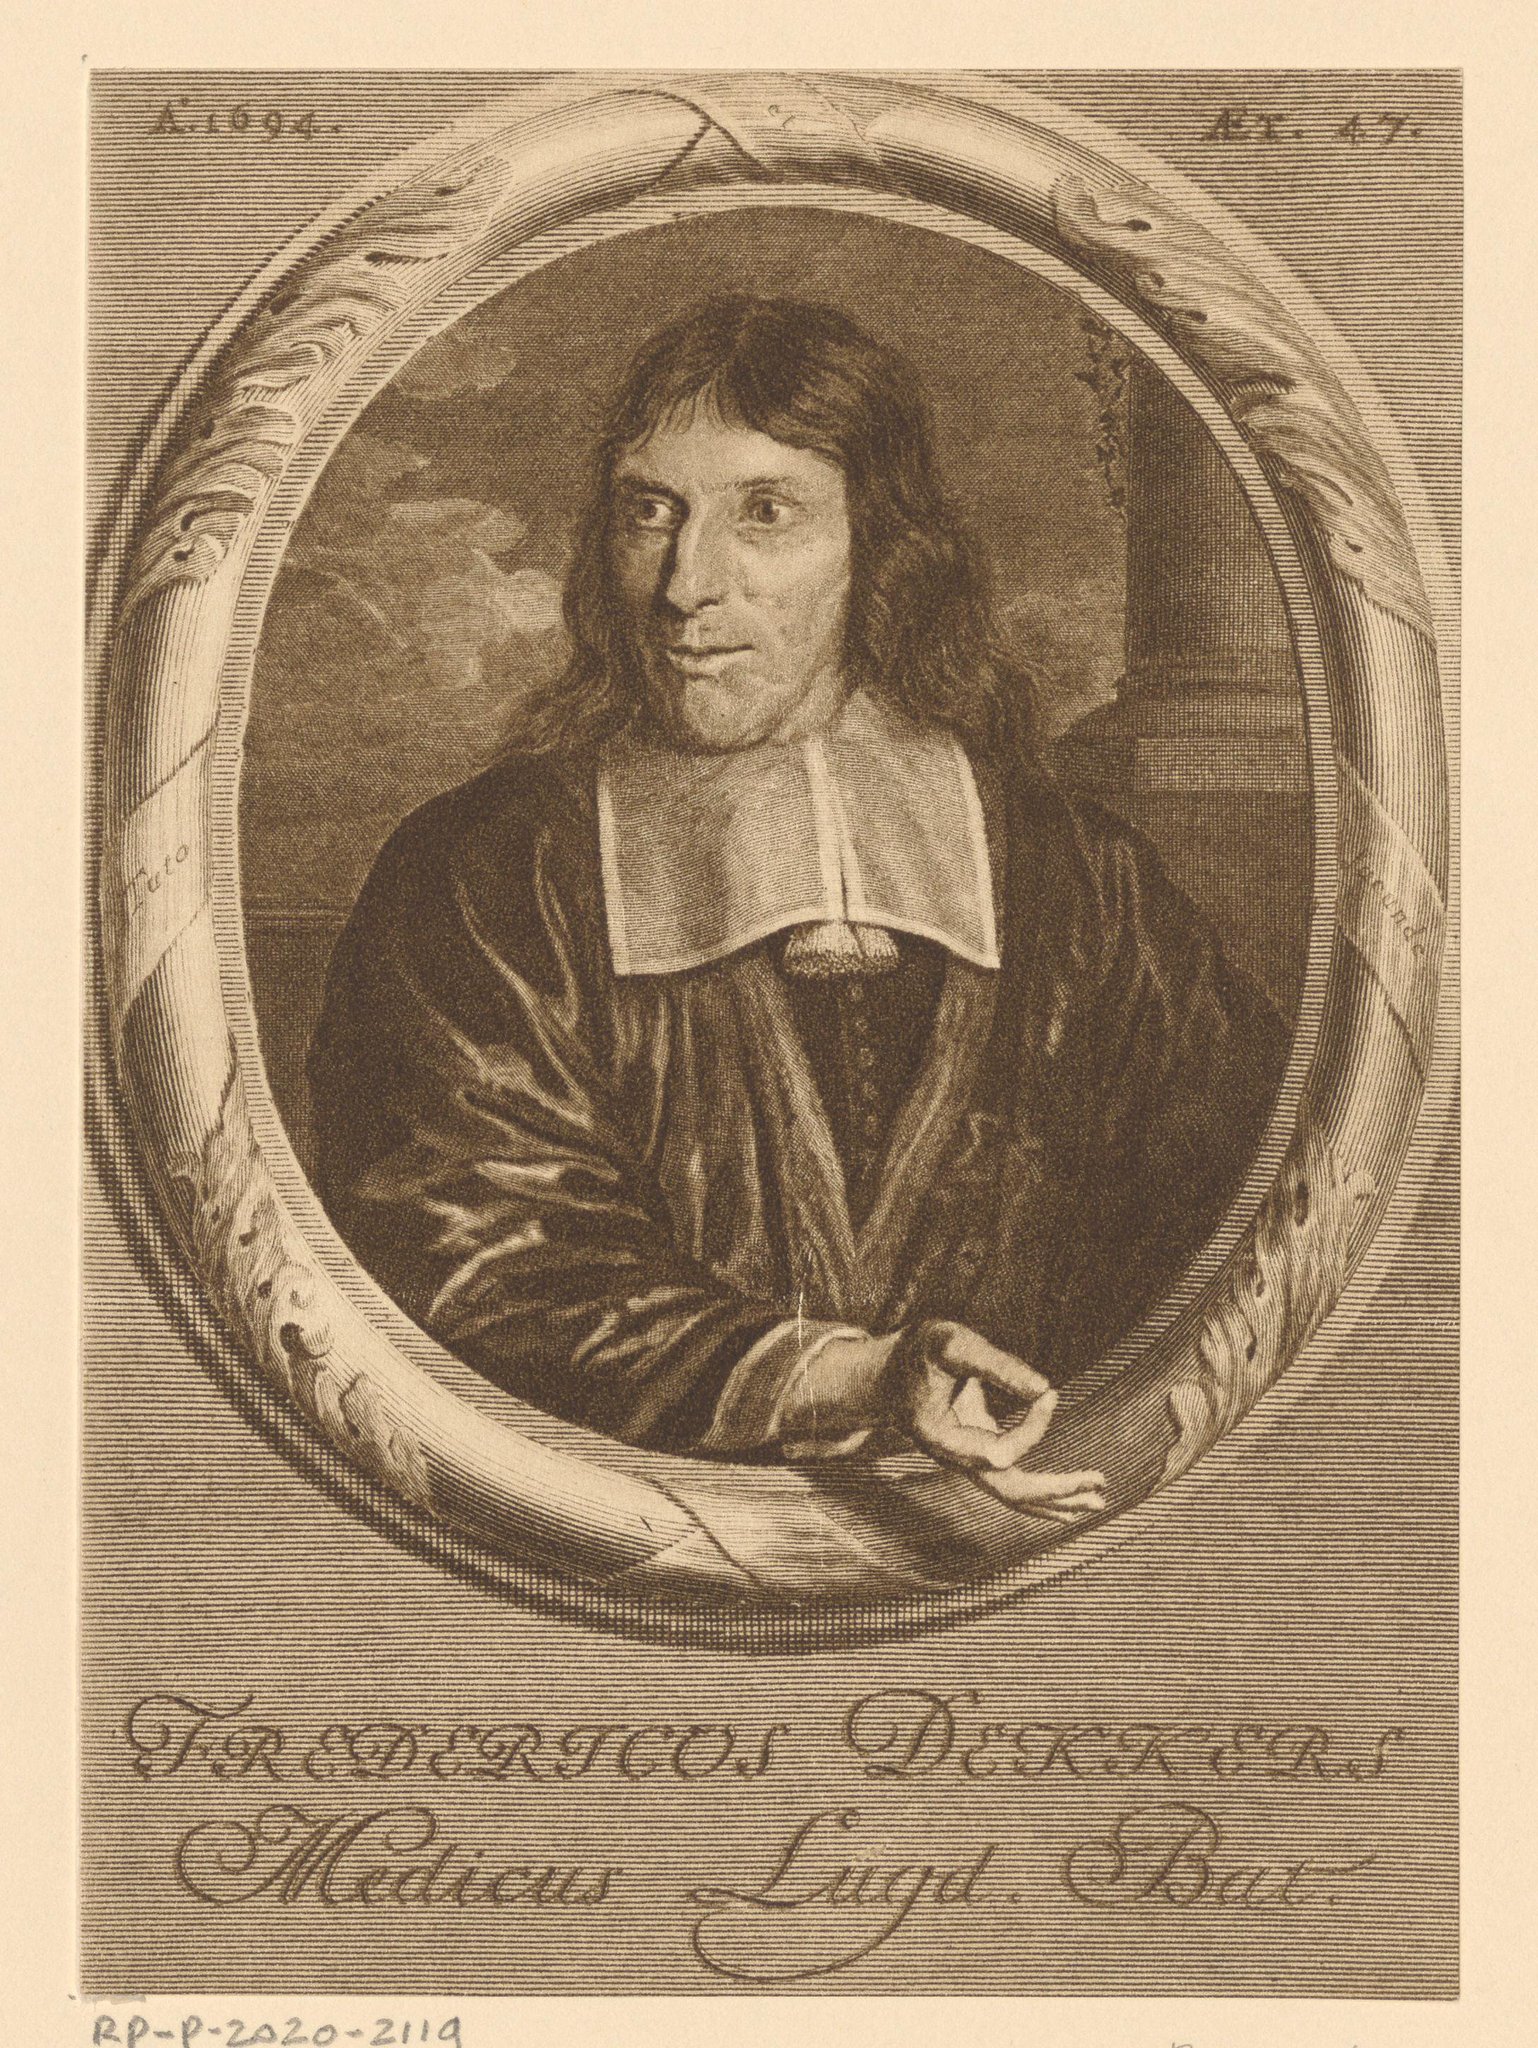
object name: photomechanical print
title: Portret van Frederik Dekkers op 47-jarige leeftijd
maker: Anonymous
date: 1895-1949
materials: paper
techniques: rotogravure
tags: den bosch, leiden, historical persons, physician, doctor